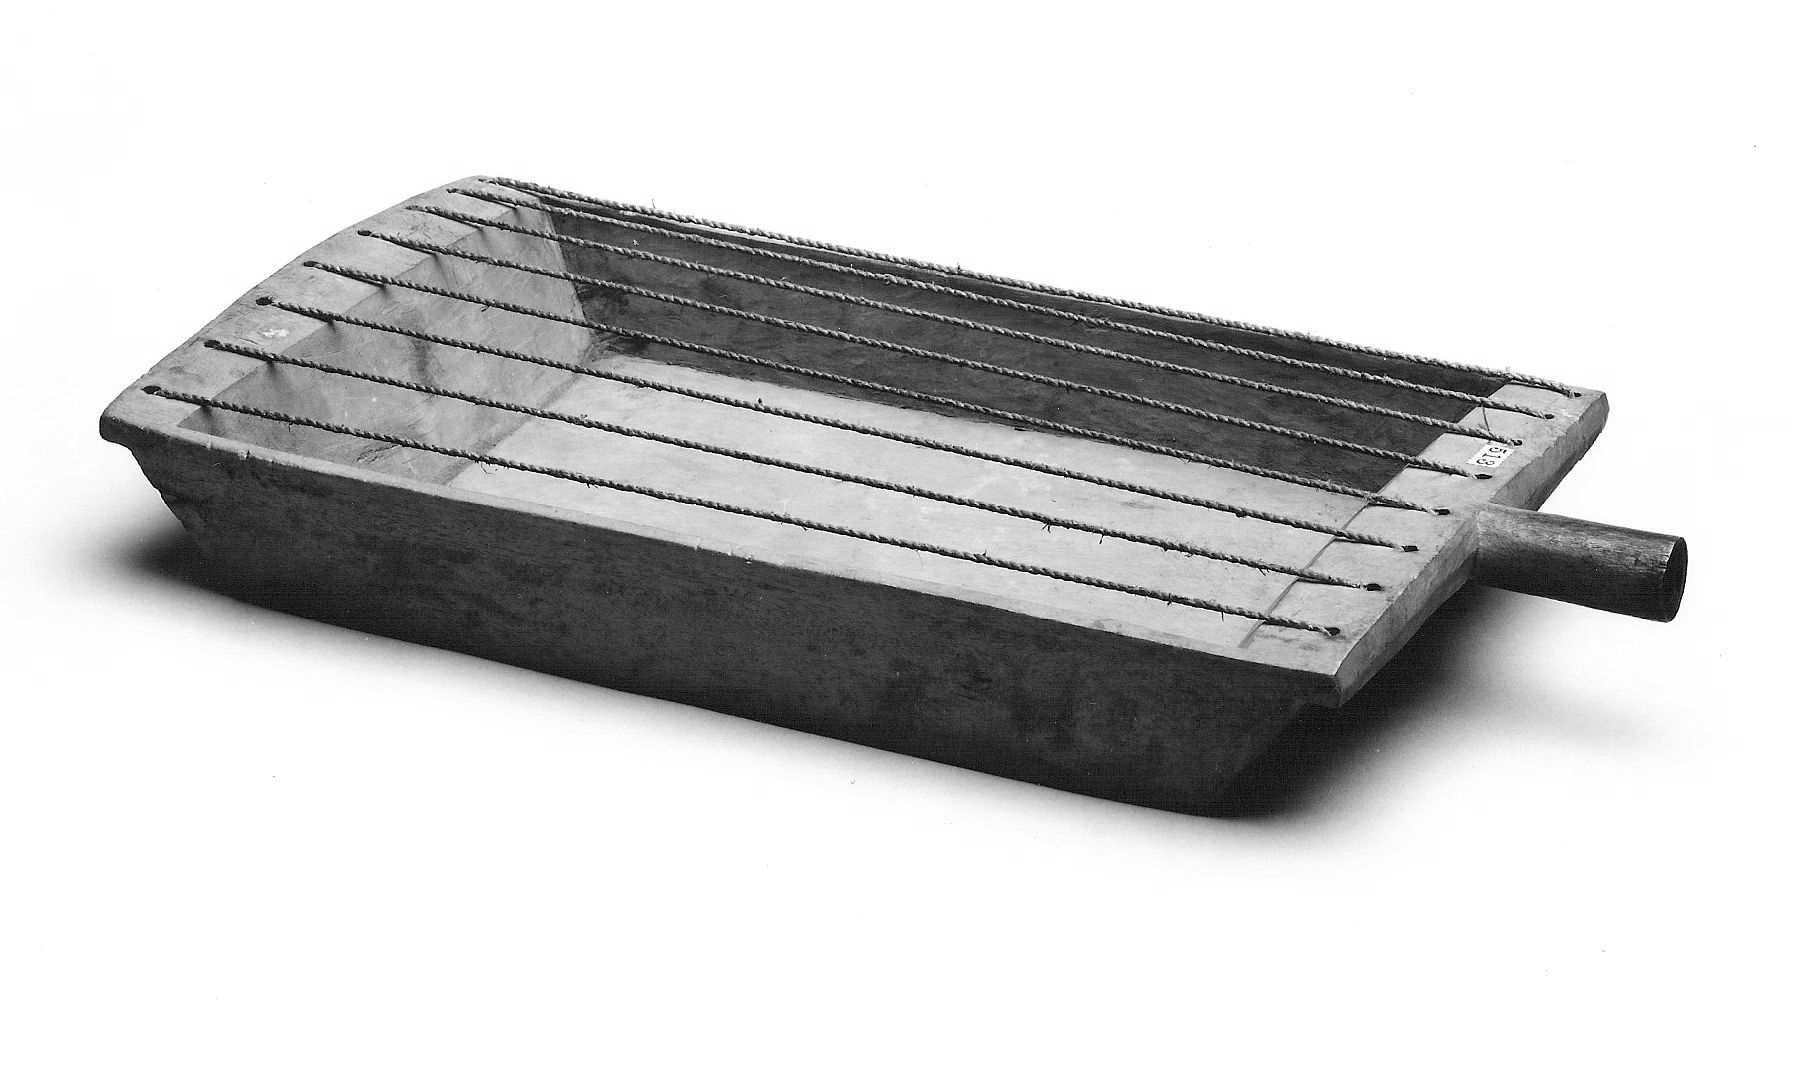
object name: trough zither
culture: congolese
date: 1867-1900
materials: wood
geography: democratic republic of congo